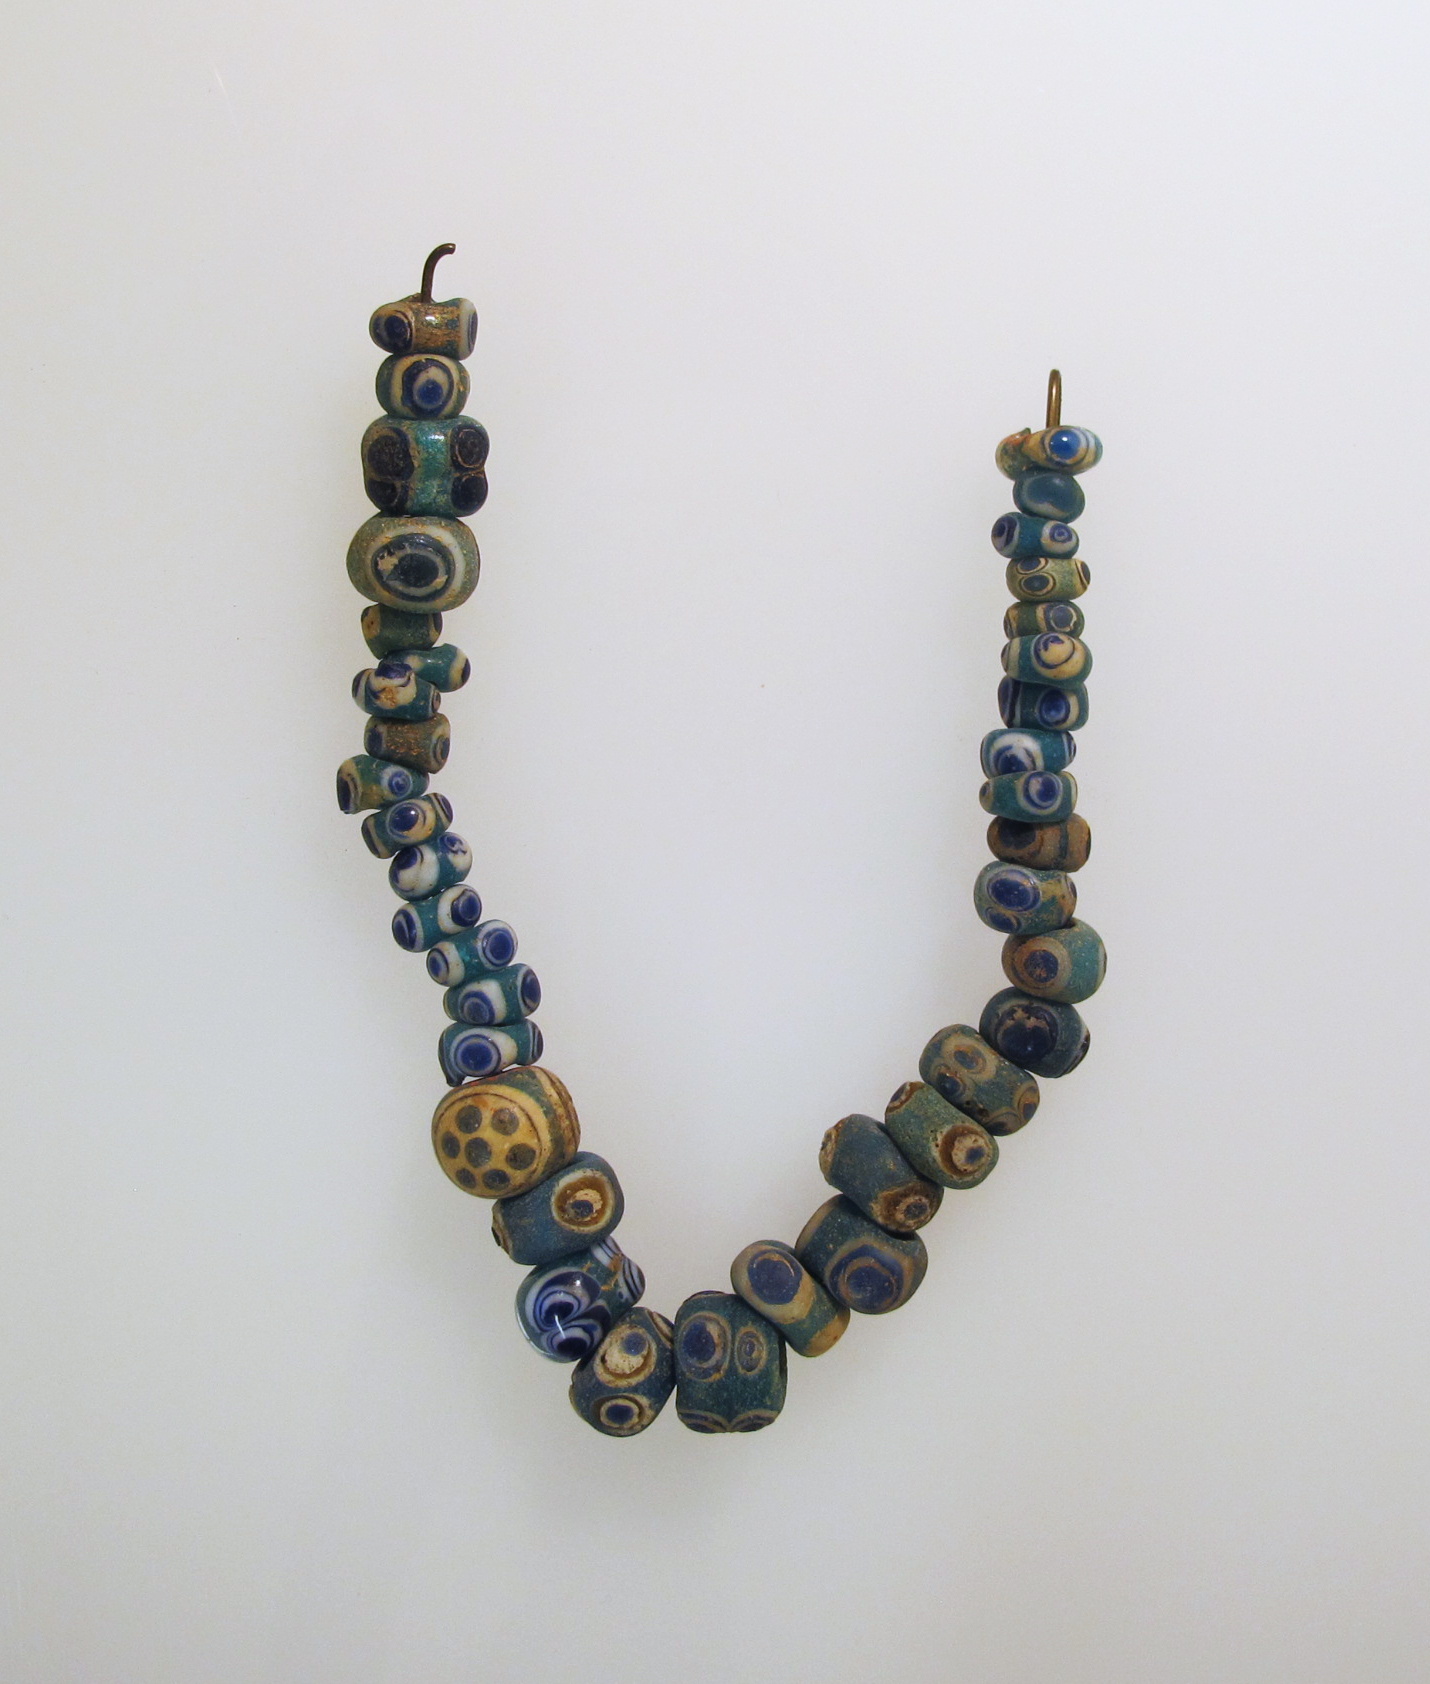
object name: bead, 38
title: Beads, 38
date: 7000 BCE-330 CE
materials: glass